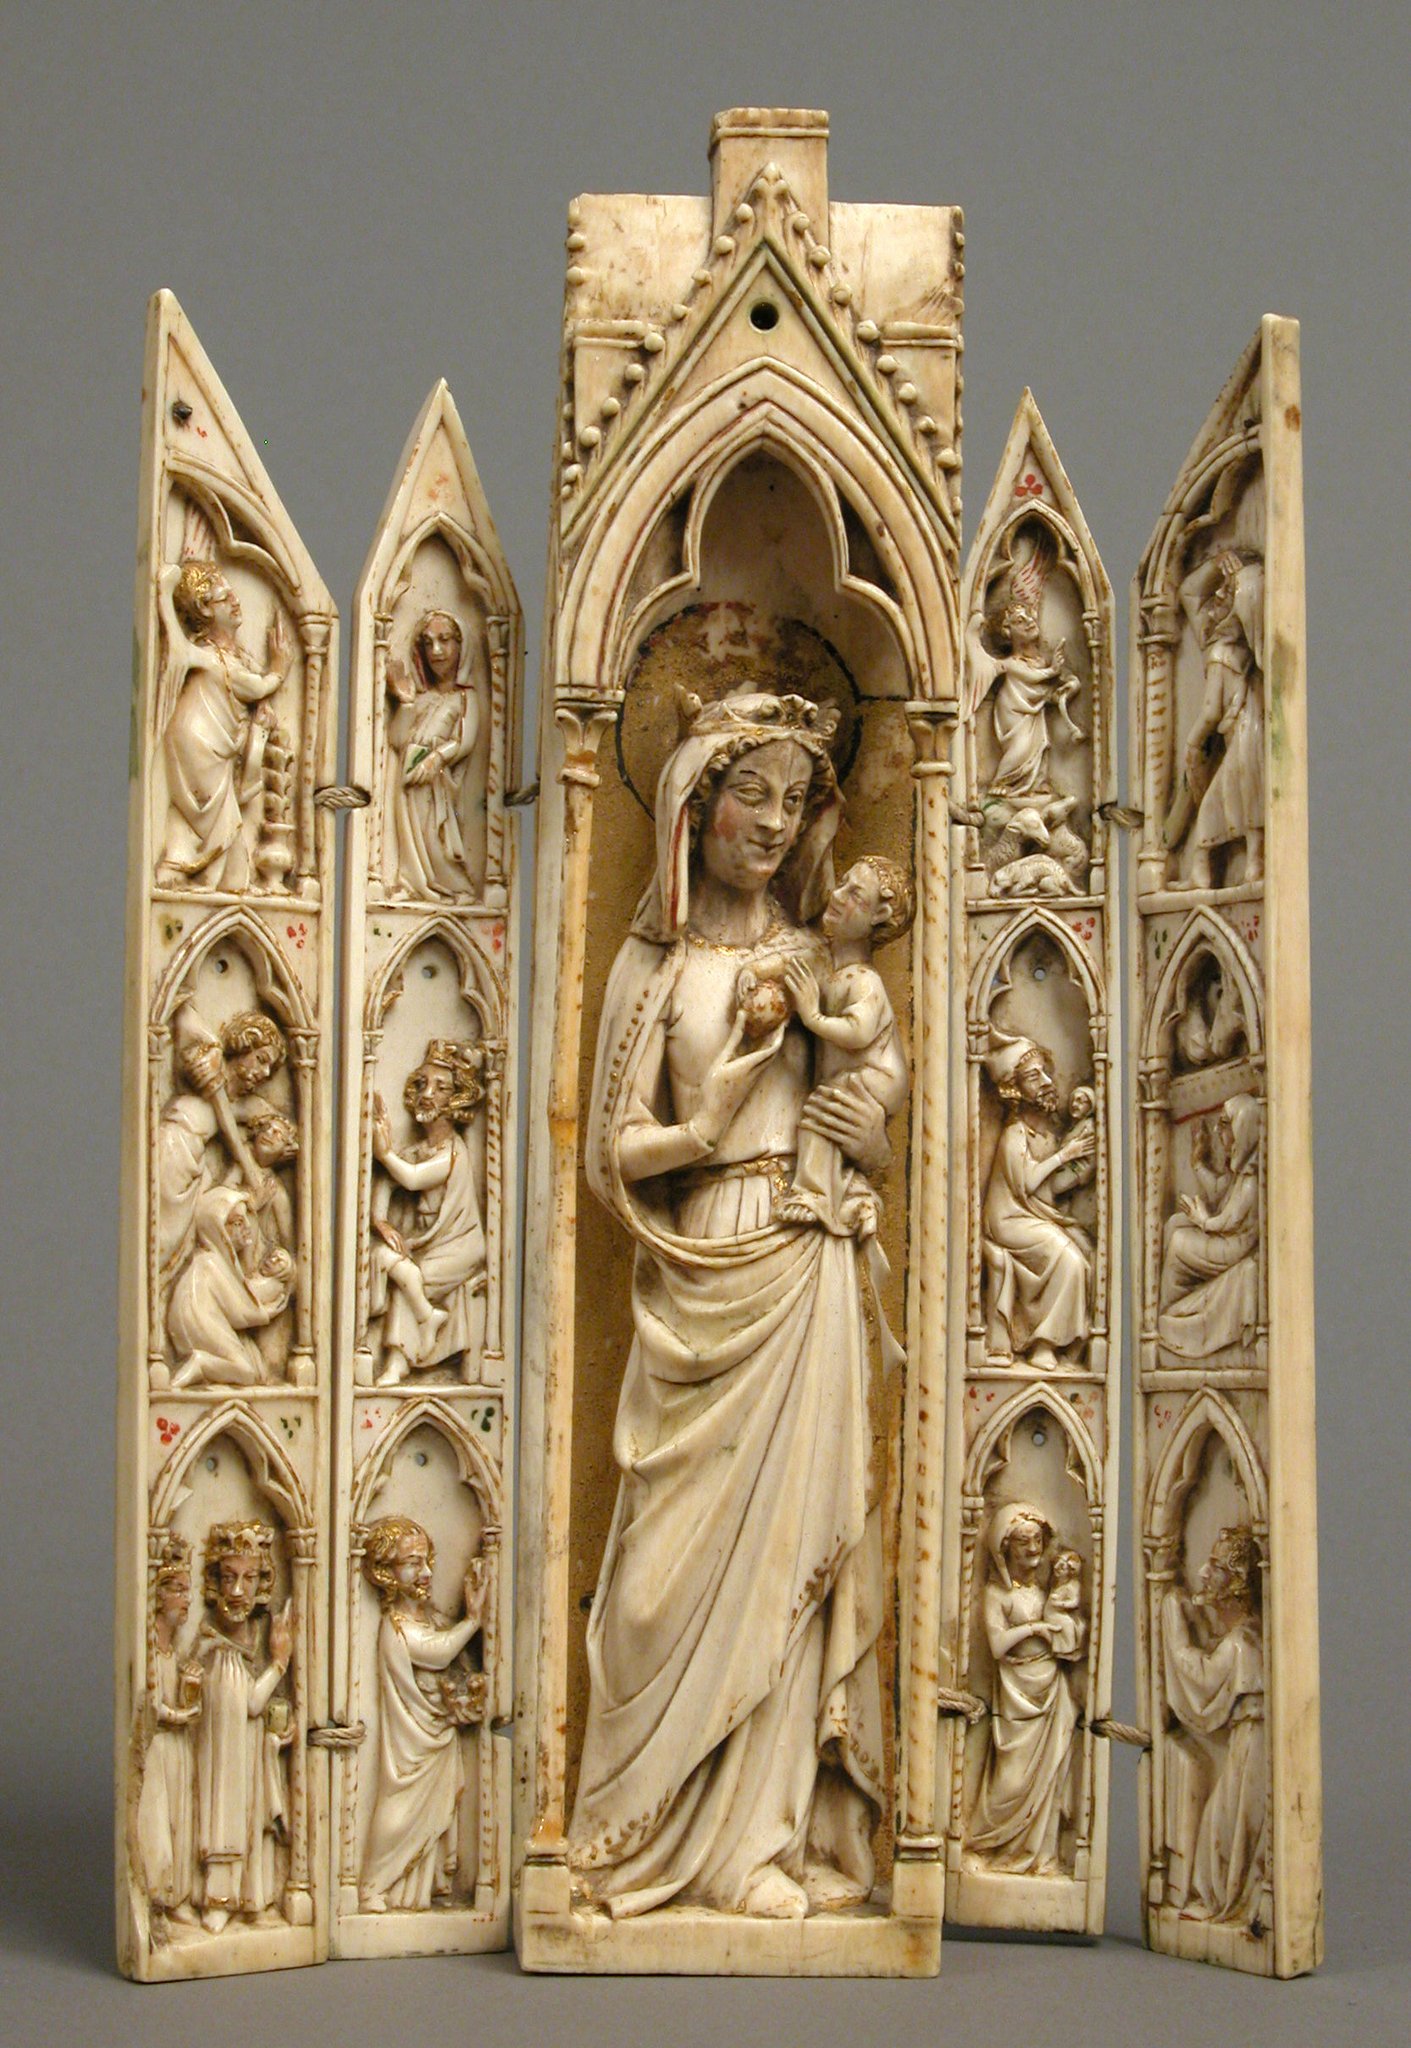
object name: folding shrine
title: Folding Shrine with Virgin and Child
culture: french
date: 1300-1325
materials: ivory, paint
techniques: gilding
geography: france